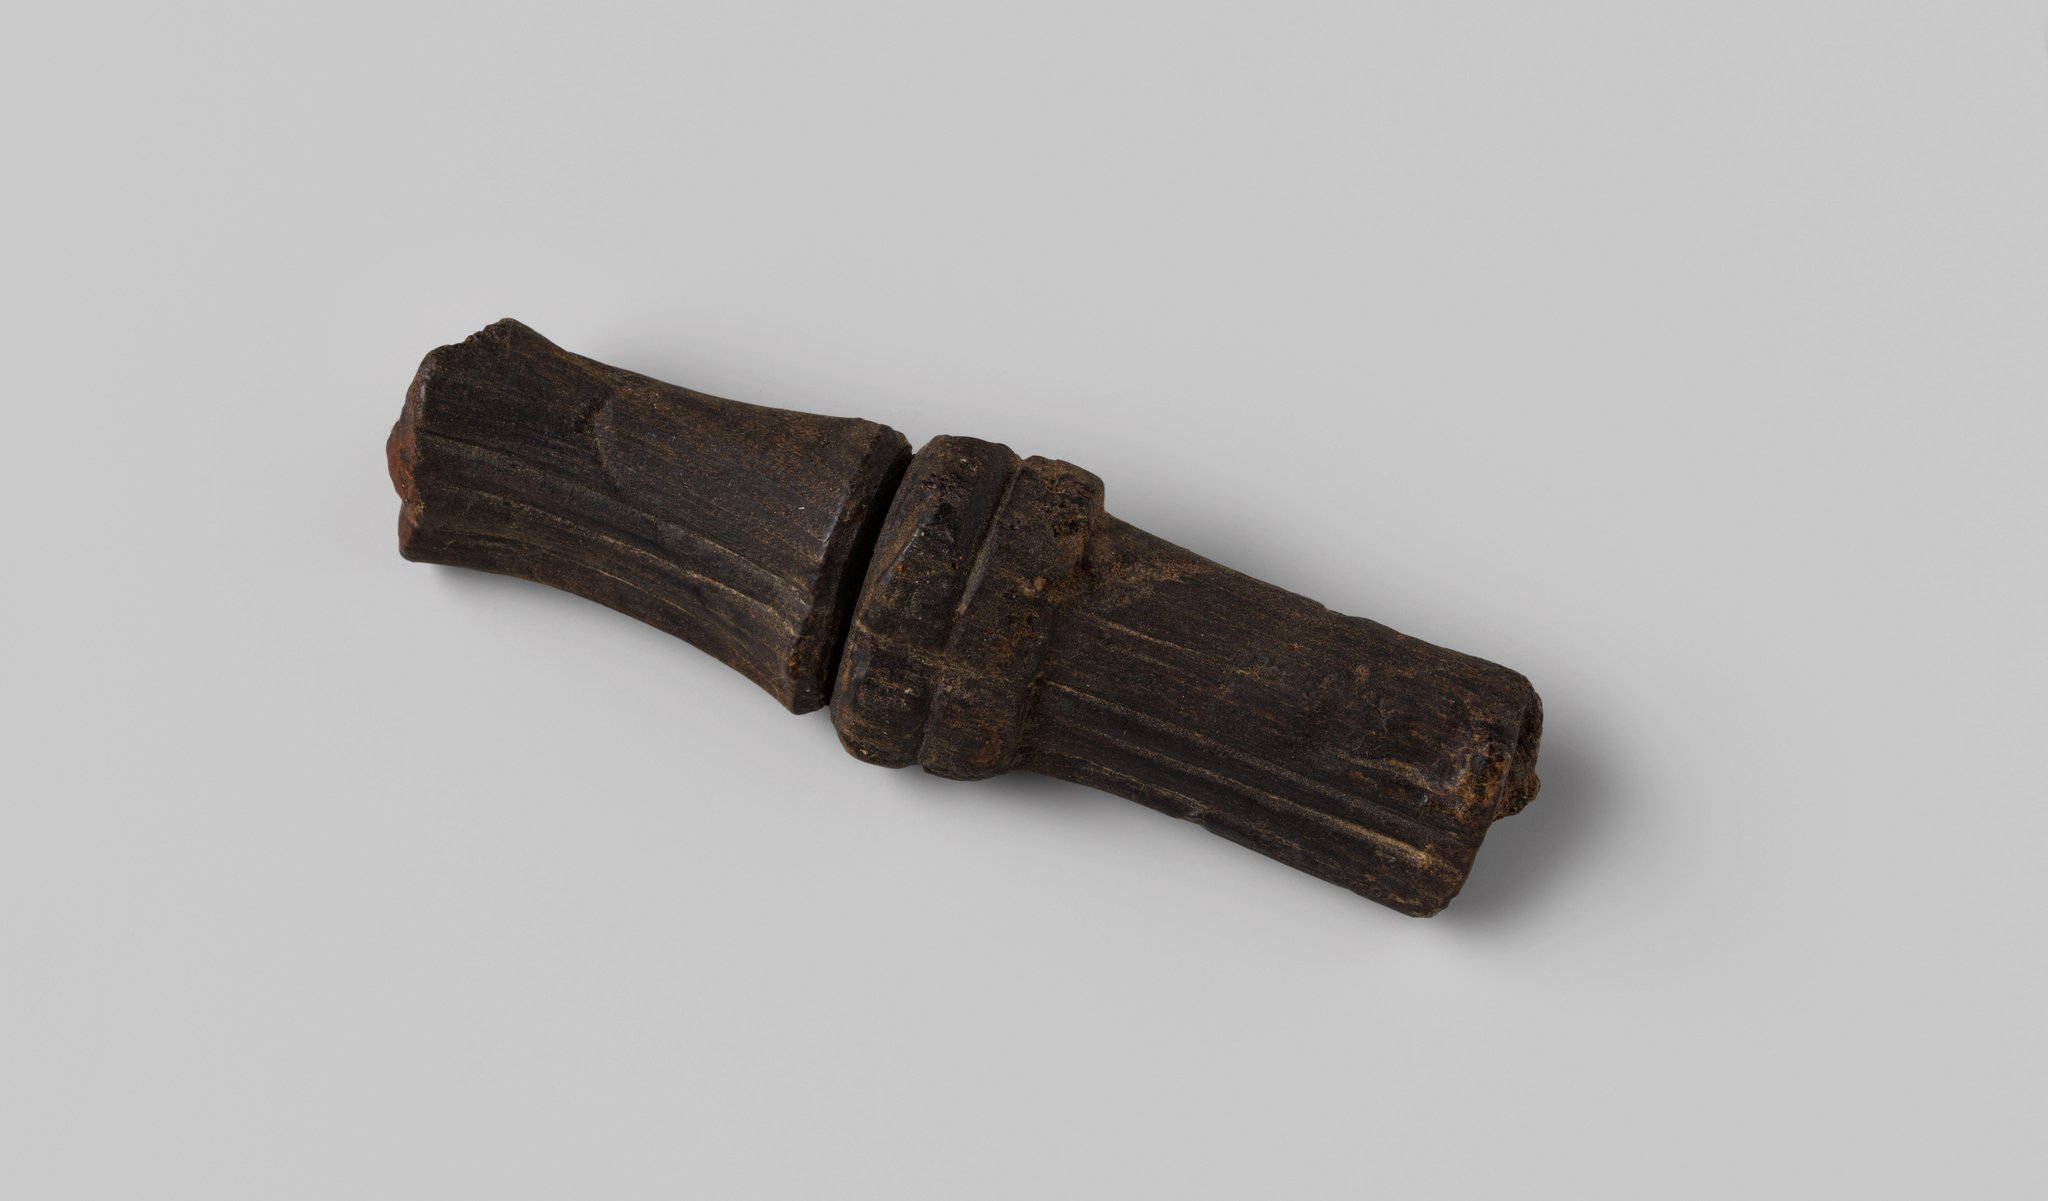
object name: belaying pin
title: Korvijnagel uit het wrak van de Oost-Indiëvaarder Hollandia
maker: Anonymous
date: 1700-1743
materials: wood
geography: netherlands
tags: verenigde oostindische compagnie, hollandia (schip), annet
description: Belaying pin; (1)fragm id. NG 1979-257H3107, lower end, eroded (12.3l, 2.8w).